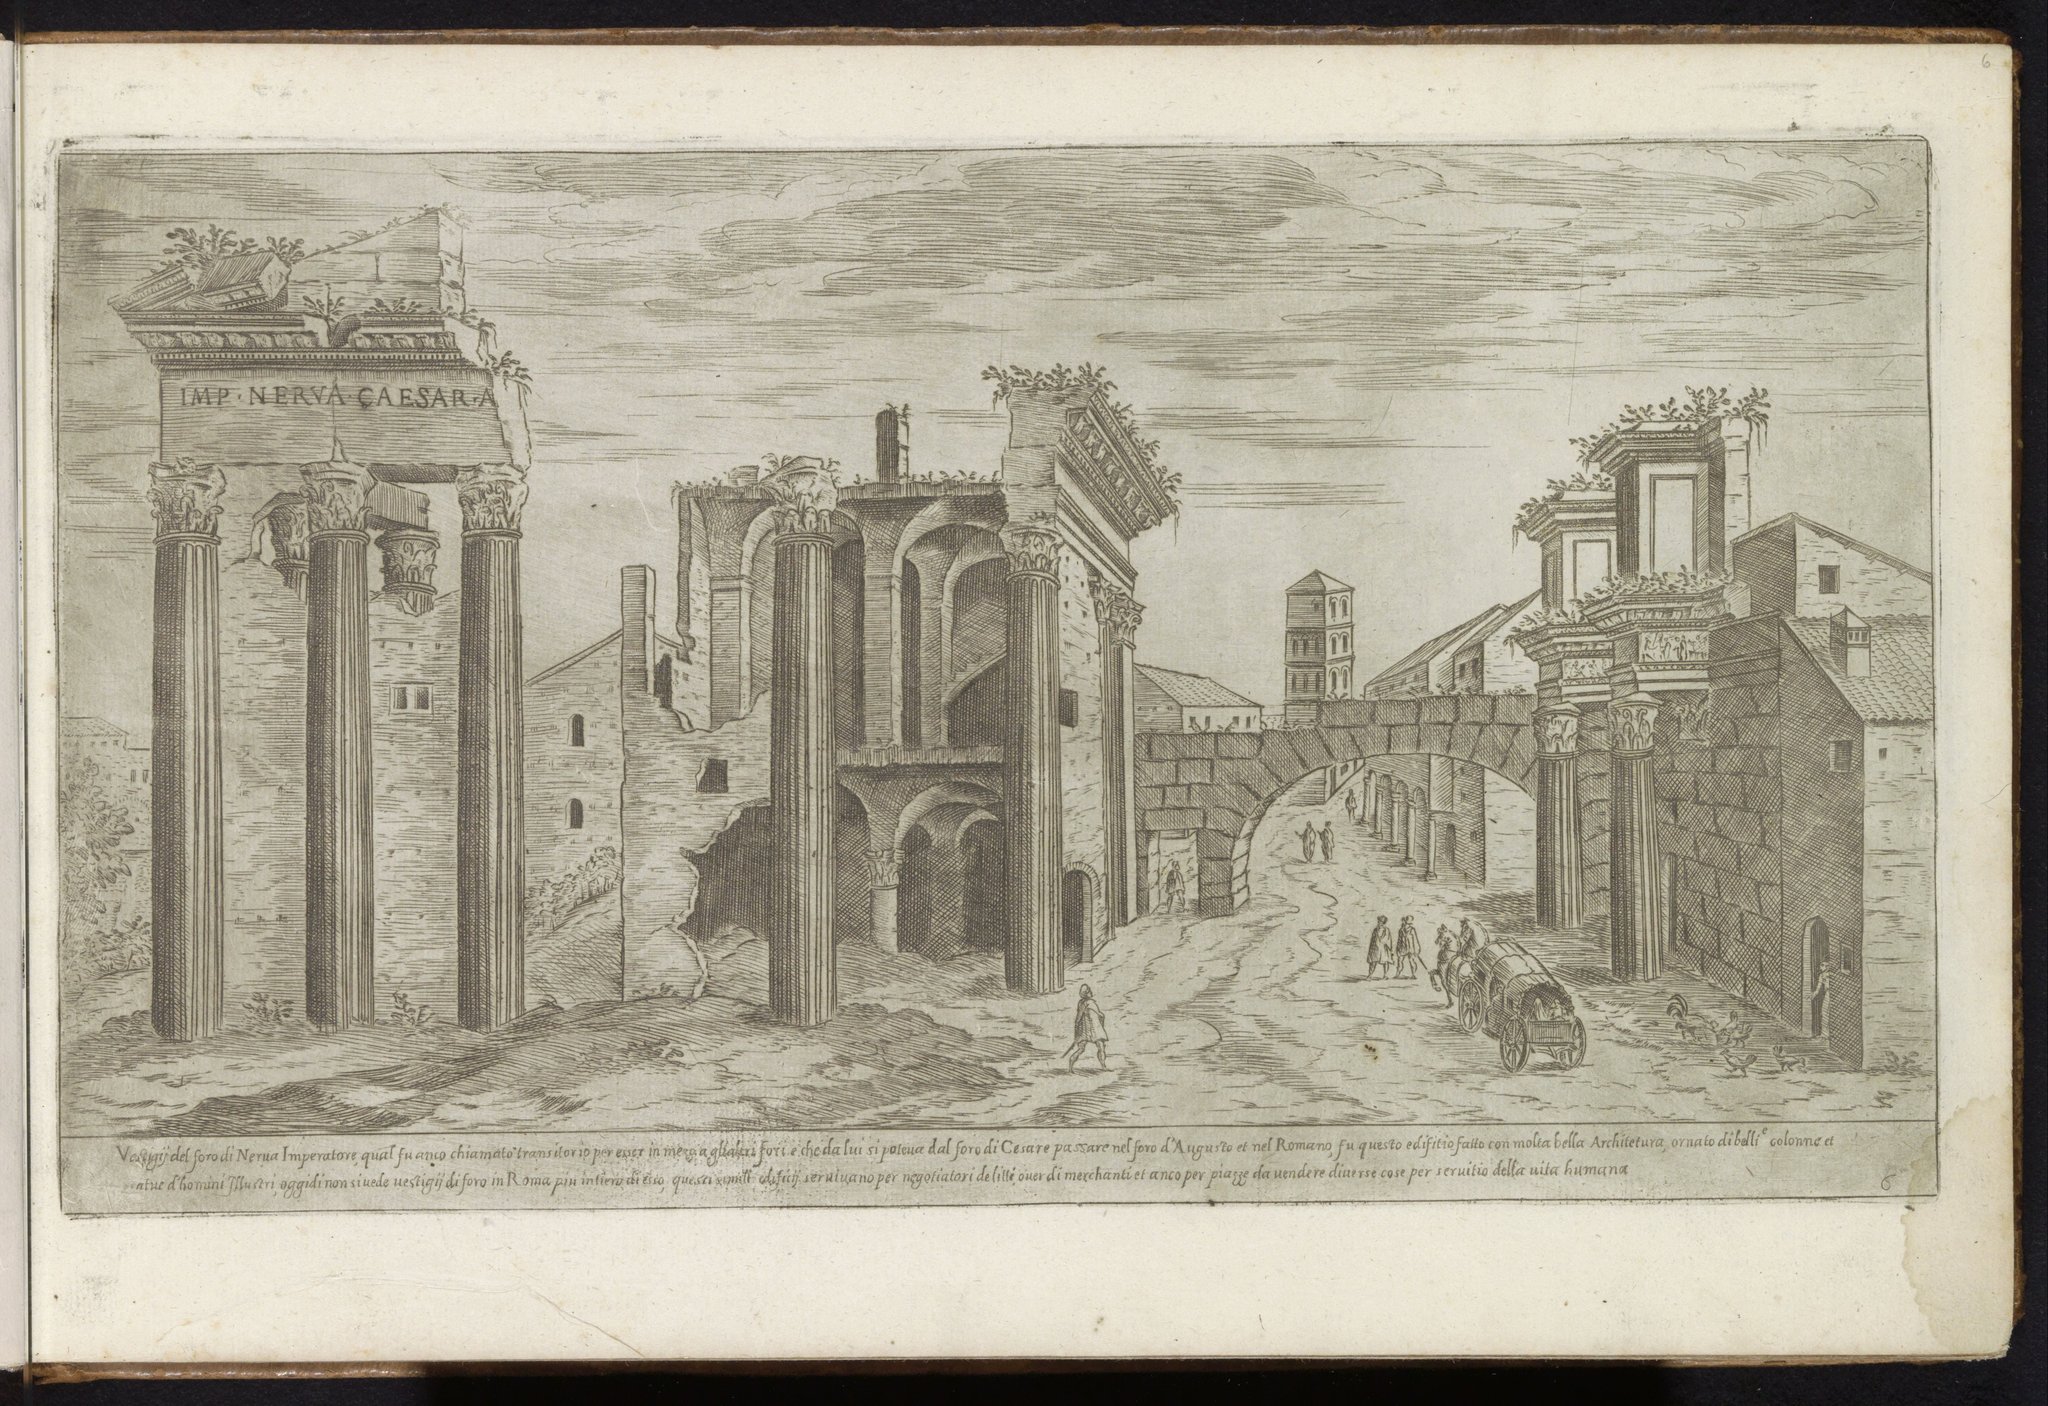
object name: print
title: I vestigi dell'antichità di Roma raccolti et ritratti in perspettiva da Stefano Du Perac Parisino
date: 1575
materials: paper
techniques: engraving, etching, intaglio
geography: rome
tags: city-view, and landscape with man-made constructions, ruin of a building ~ architecture, landscape with ruins, temple, shrine ~ roman religion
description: Gezicht op de ruïnes op het Forum van Nerva te Rome. Onderschrift in het Italiaans. Prent maakt deel uit van een album.